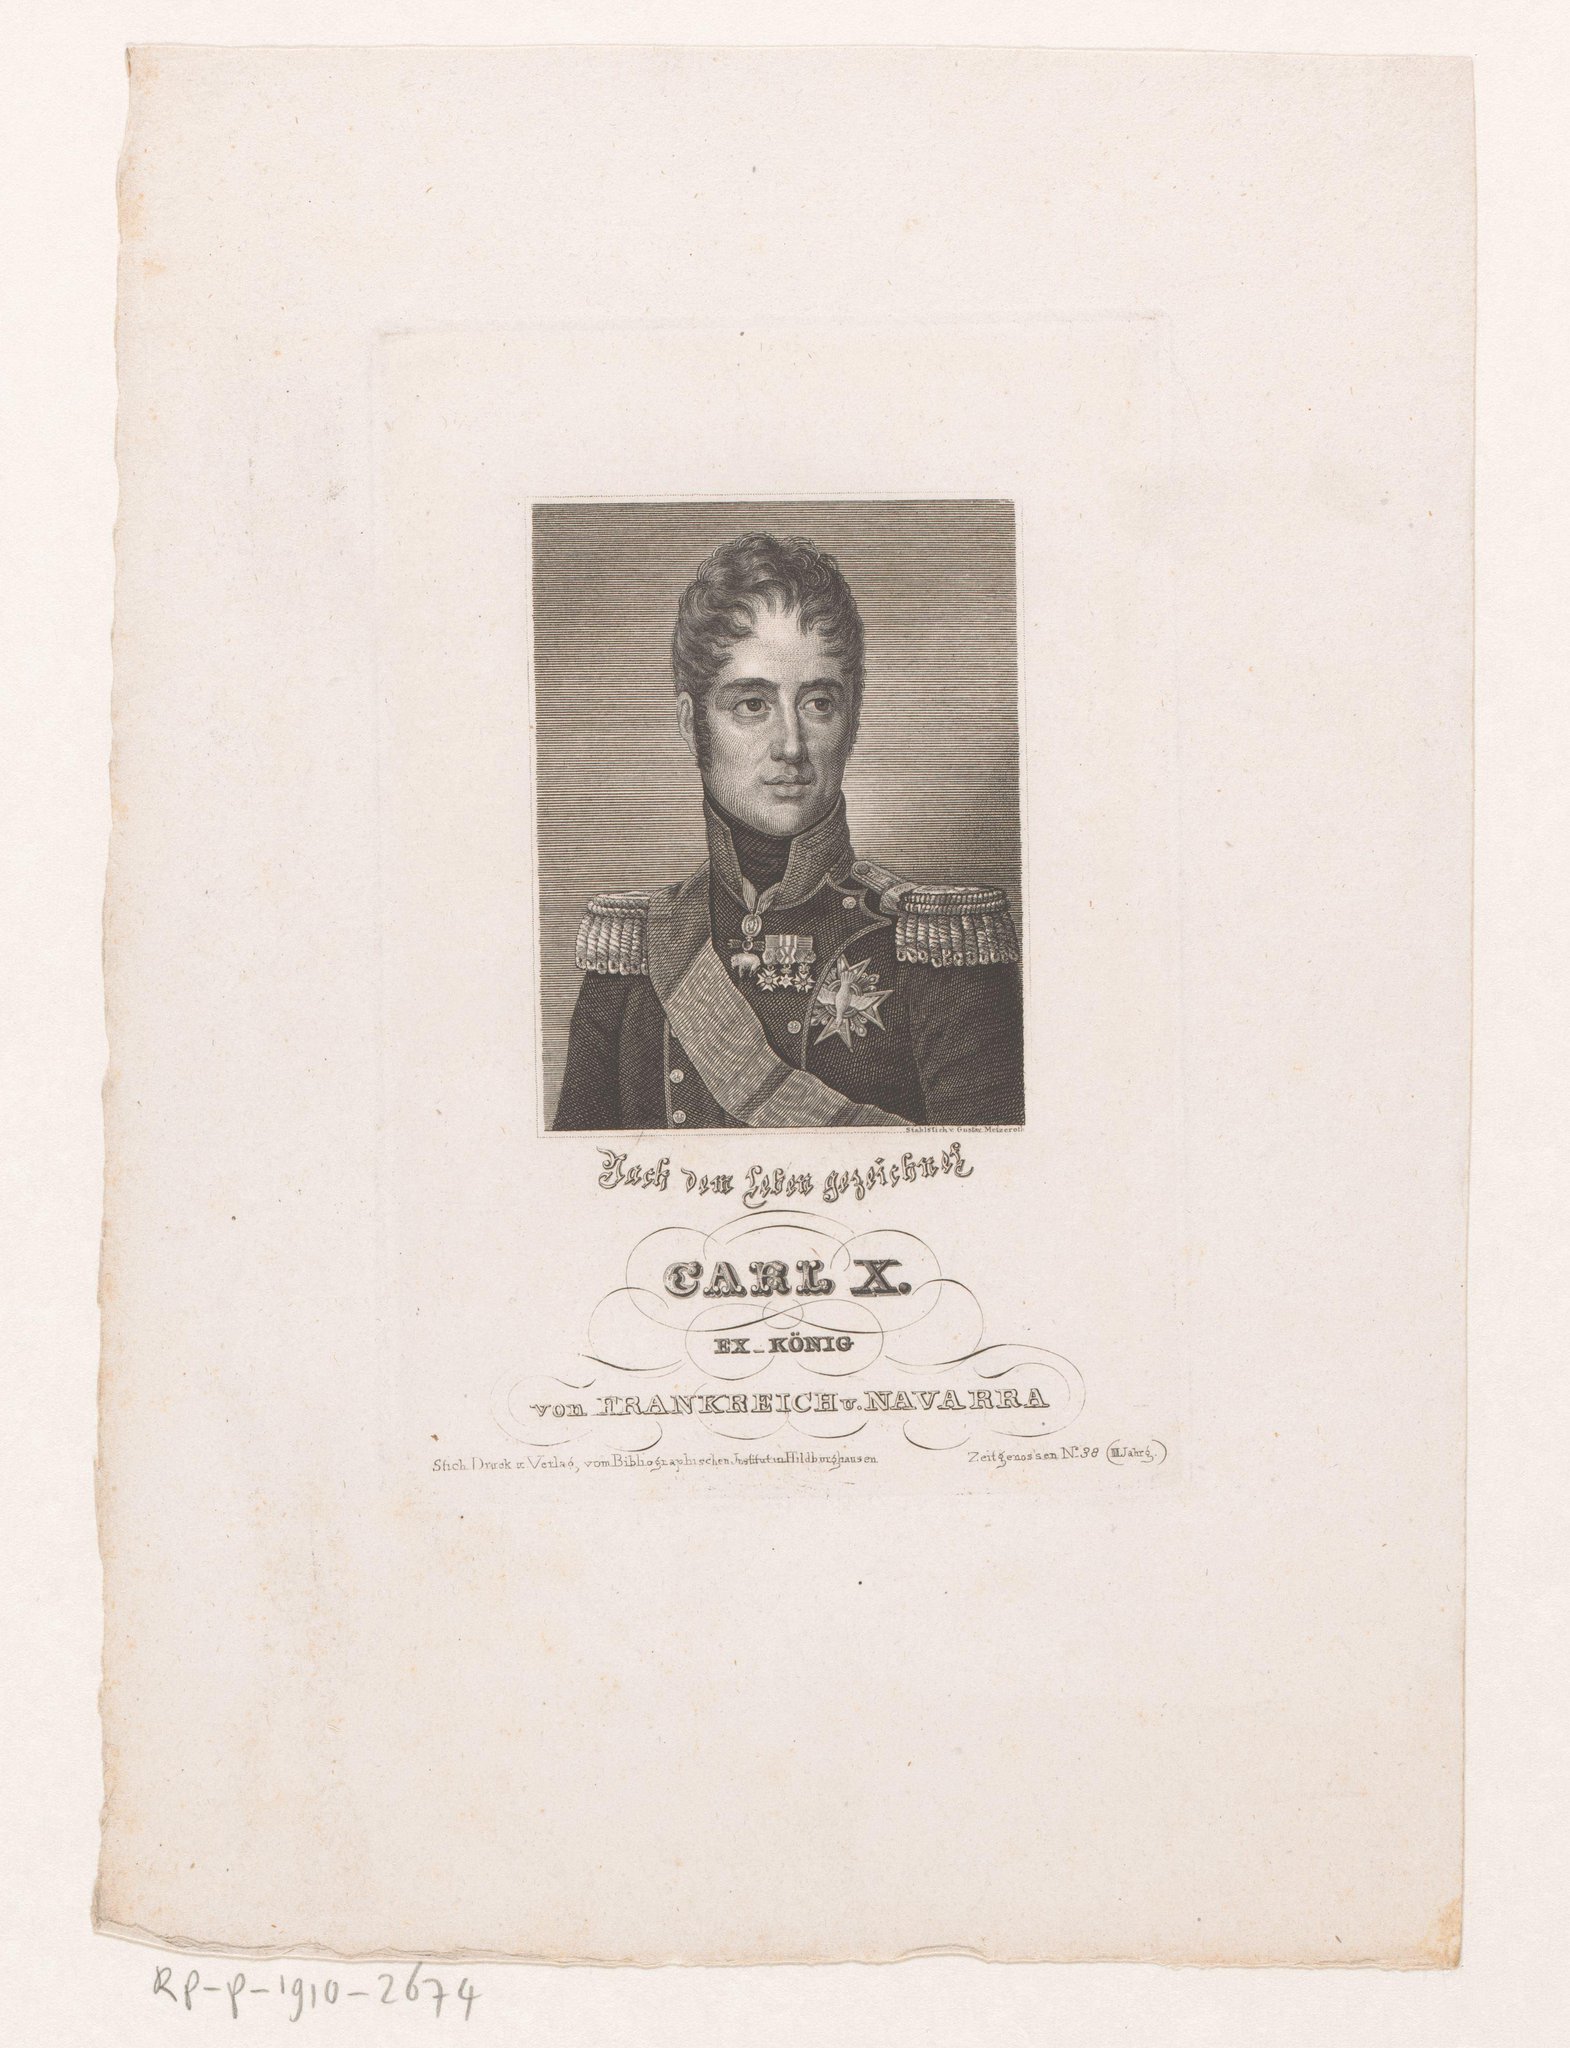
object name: print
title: Portret van koning Karel X van Frankrijk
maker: g. metzeroth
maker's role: print maker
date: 1829-1840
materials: paper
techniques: engraving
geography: hildburghausen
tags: historical persons, knighthood order of the golden fleece - insignia of a knighthood order, e.g.: badge, chain (with name of order)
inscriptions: collector's mark: Lugt 2228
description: Afkomstig uit de portretserie 'Zeitgenossen', uitgegeven tussen 1829 en circa 1840.